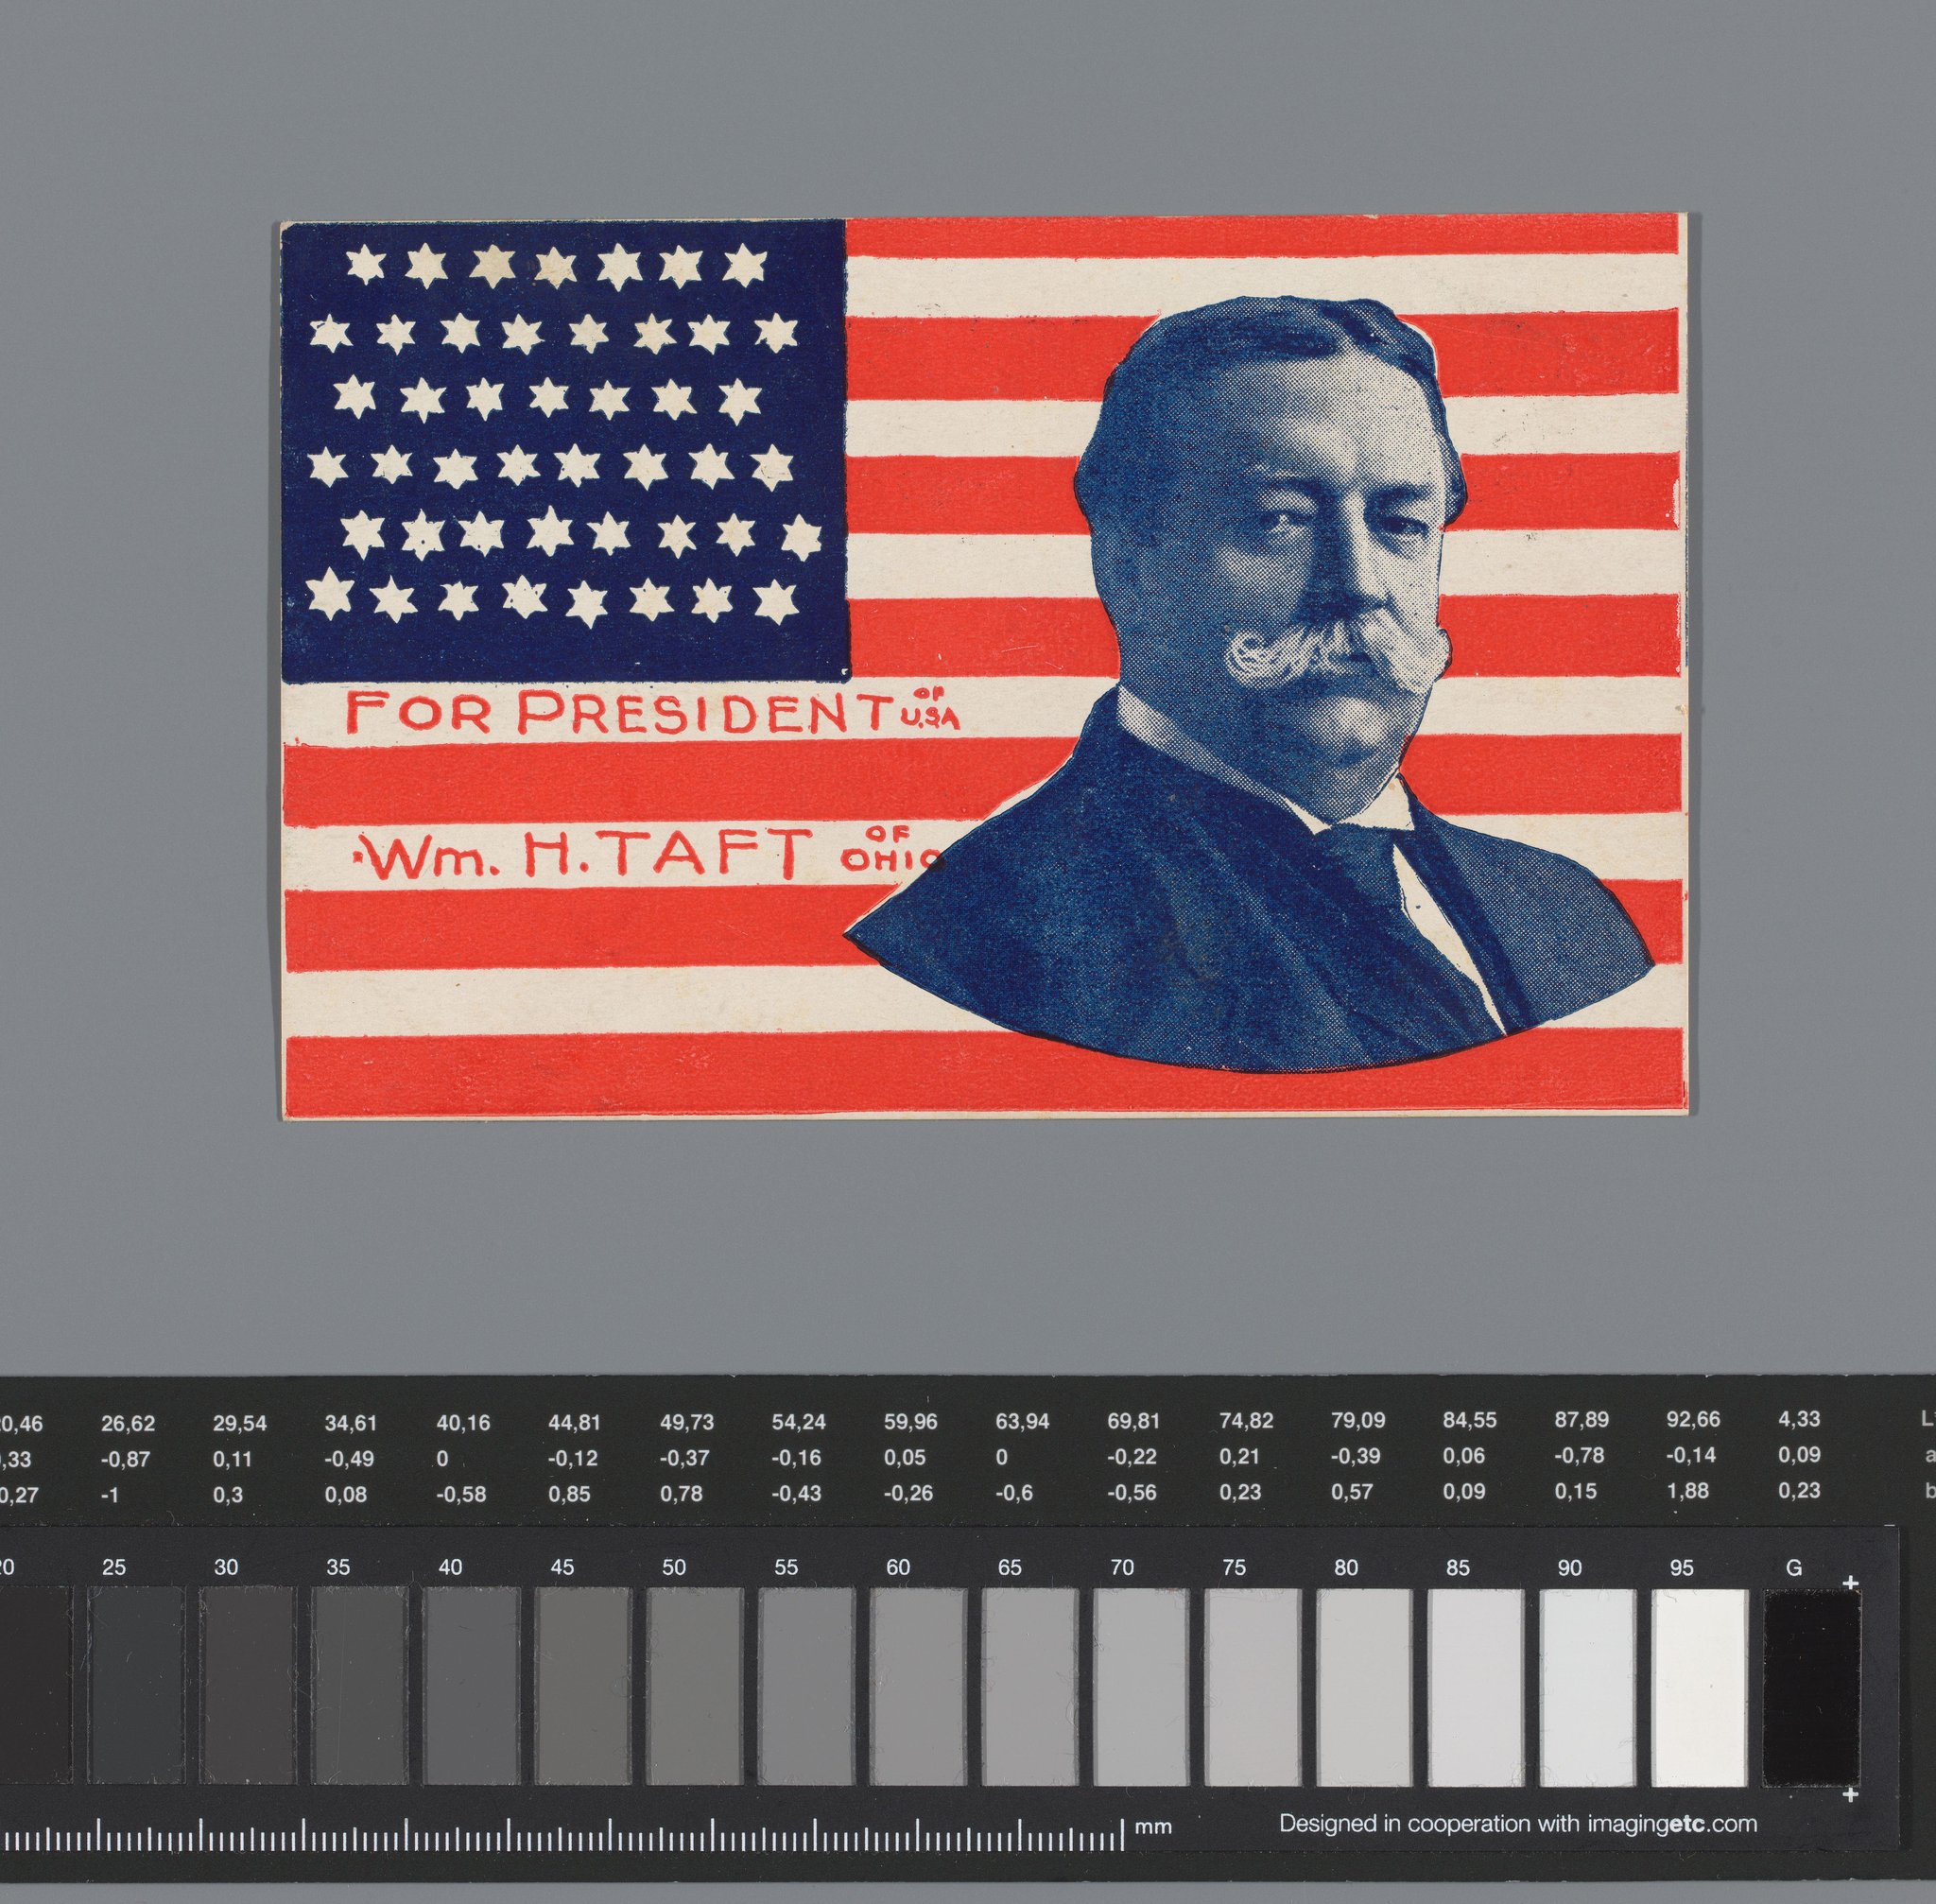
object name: ansichtkaart, prentbriefkaart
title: Prentbriefkaart gebruikt als campagnemateriaal voor de presidentskandidaat William Howard Taft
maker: Anonymous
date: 1908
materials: photographic support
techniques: photography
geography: united states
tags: cincinnati, politician, united states of america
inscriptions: inscription: ‘President of U.S.A. / Wm. H. TAFT of OHIO’